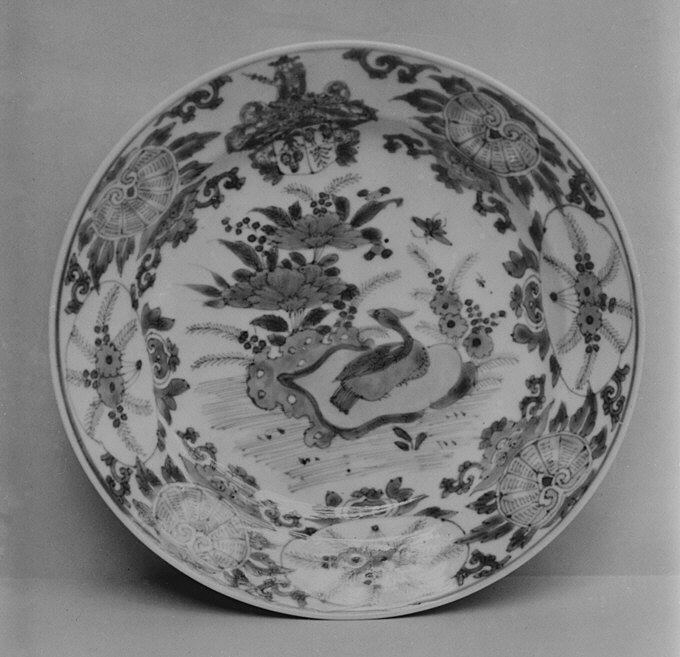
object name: dish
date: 1700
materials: hard paste porcelain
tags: birds,flowers